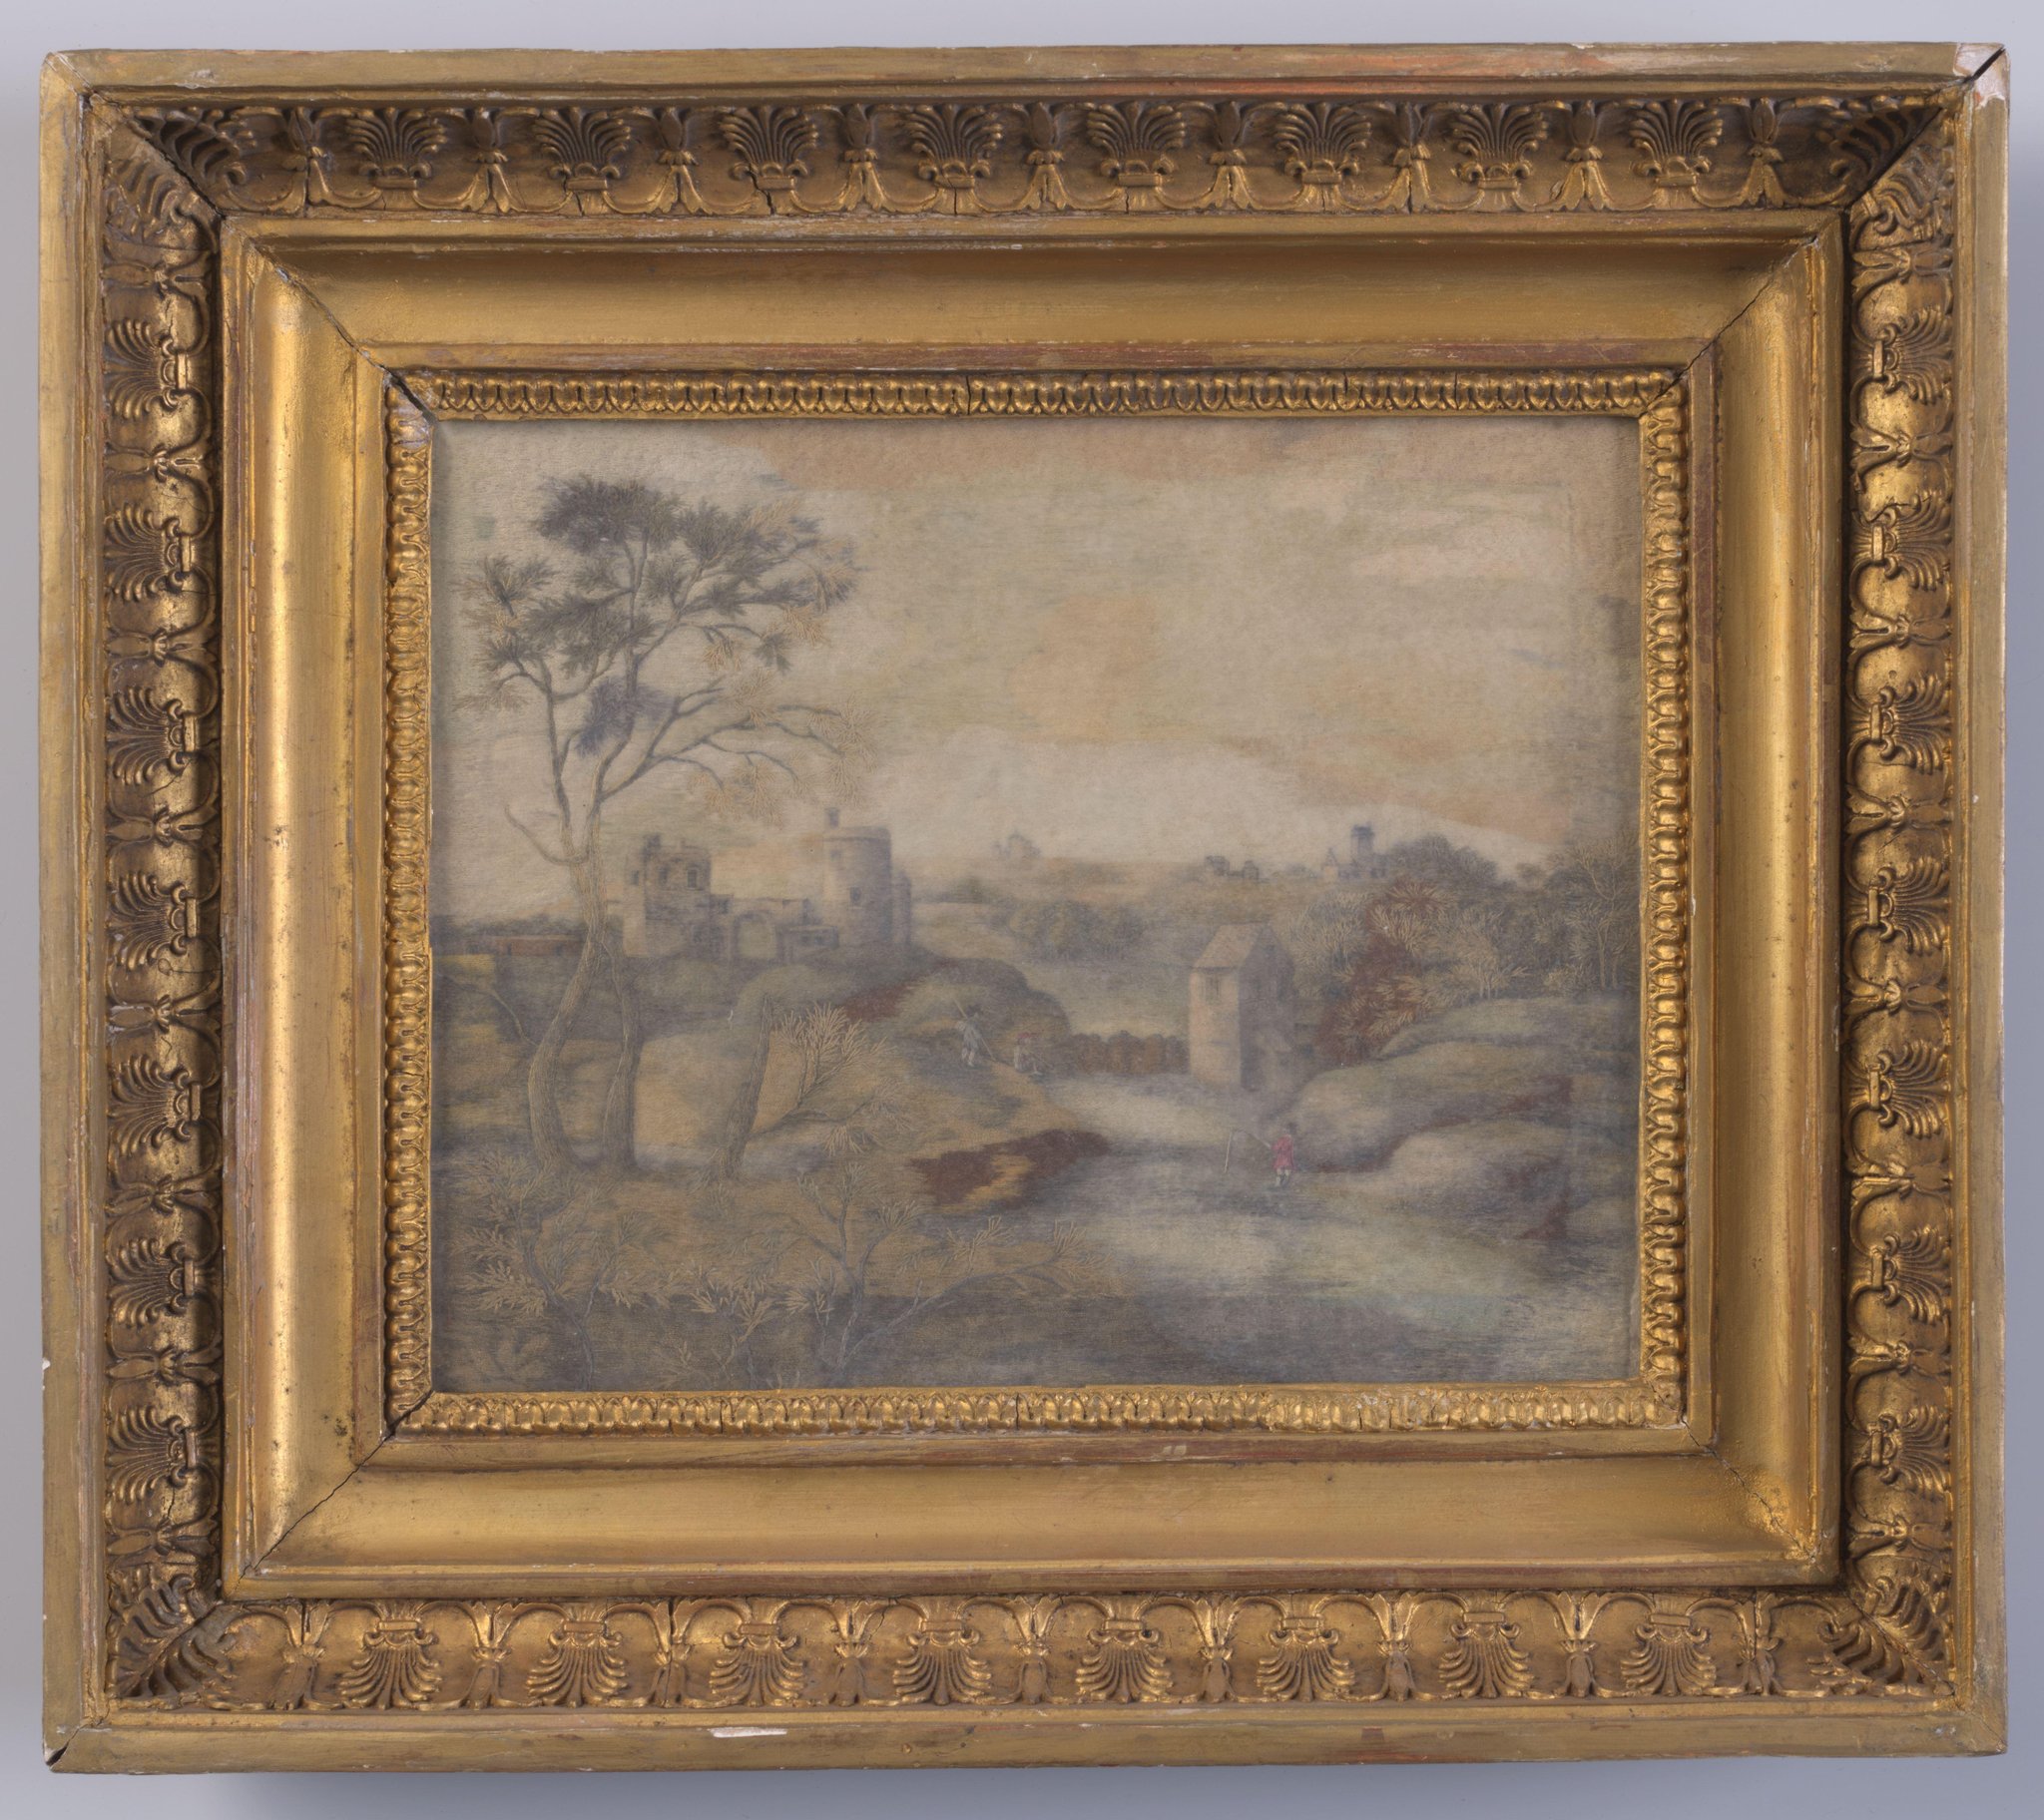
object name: tableau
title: Geborduurd tableau van wol op zijde.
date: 1785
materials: silk, wool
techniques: embroidered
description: Geborduurd tableau van wol op zijde. De voorstelling betreft een rivierlandschap met heuvels. In het landschap staan "Spaans" aandoende boerderijen met torens en drie figuren, waarvan een staat te hengelen. Links op de voorgrond staat een hoge, ijle boom. Het tableau zit in een vergulde lijst. Bij het tableau wordt een tableau bewaard met invnr. BK-NM-284-B.